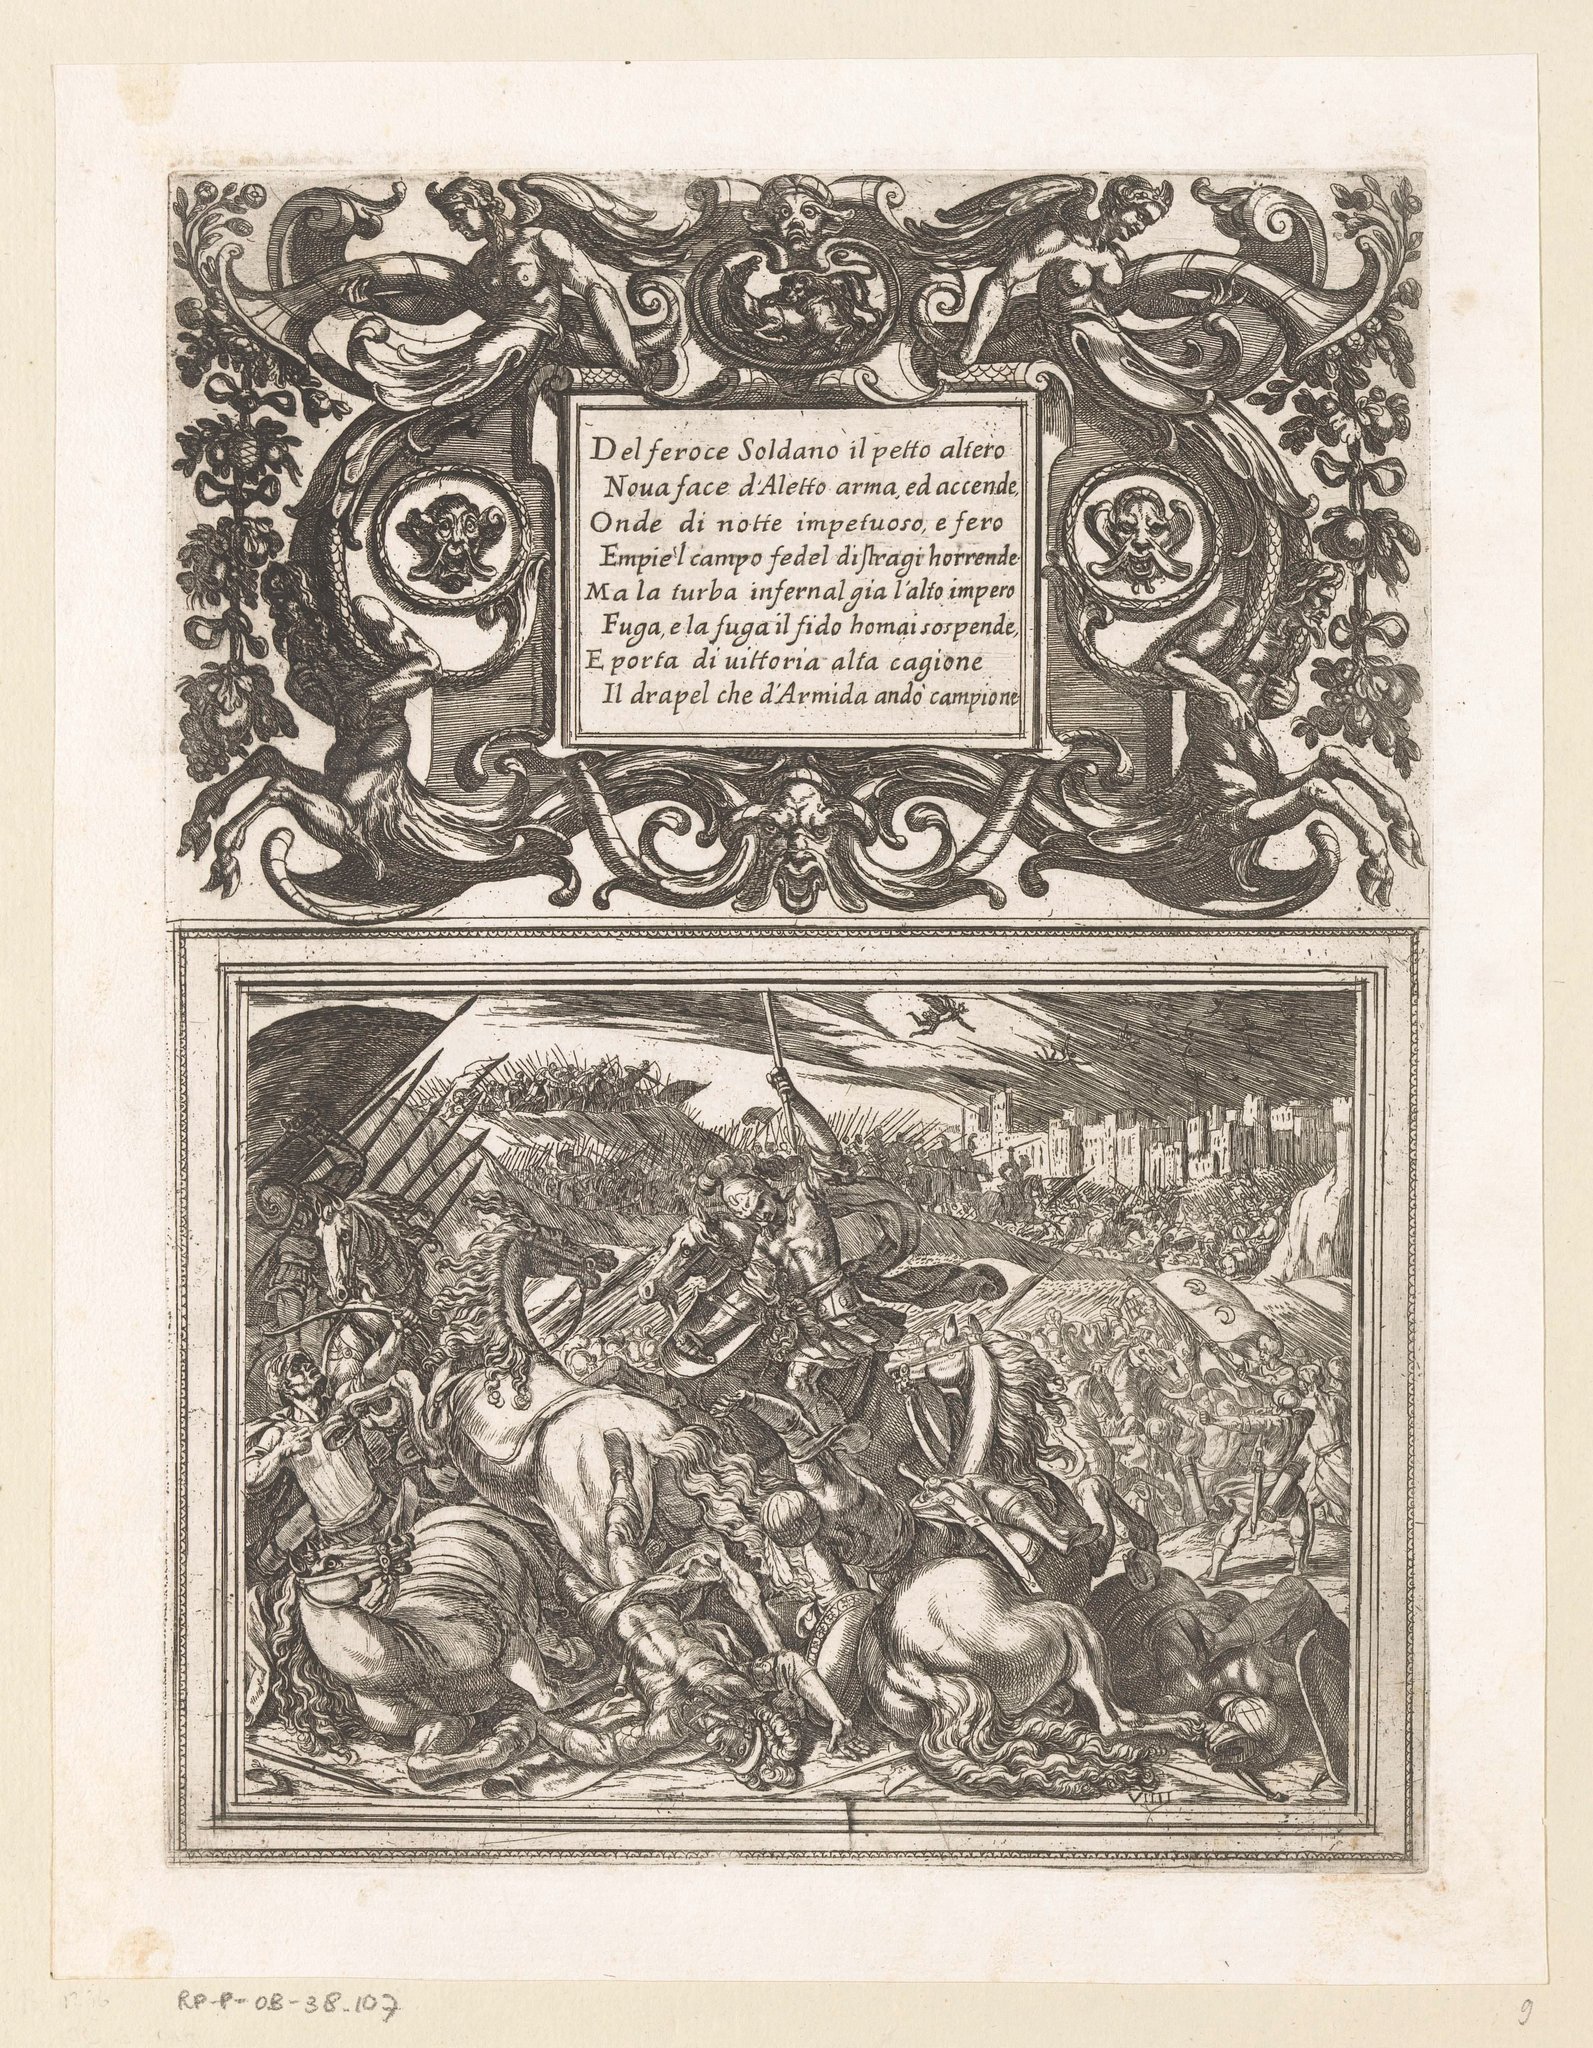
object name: print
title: Jeruzalem verlost (deel 3)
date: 1565-1630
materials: paper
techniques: etching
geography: italy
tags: ornaments ~ art, the archangel michael (often in armour with sword or lance), battle, warfare; military affairs (+ cavalry, horsemen), militant proselytizing: religious war, crusade, etc., ornament ~ cartouche, (scenes from) specific works of literature: tasso, gerusalemme liberata, knight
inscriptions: collector's mark: Lugt 240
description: Deze prent maakt deel uit van een reeks van twintig prenten met ornamentele sierlijsten met daarin voorstellingen van scènes uit Tasso's 'Jeruzalem verlost', een episch gedicht geschreven door de Italiaanse dichter Torquato Tasso en voor het eerst gepubliceerd in 1581. Het verhaal vertelt grotendeels in fictie over de Eerste Kruistocht waarin de christenen, geleid door Godfried van Bouillon, de strijd aangaan met de moslims om het Beleg van Jeruzalem.